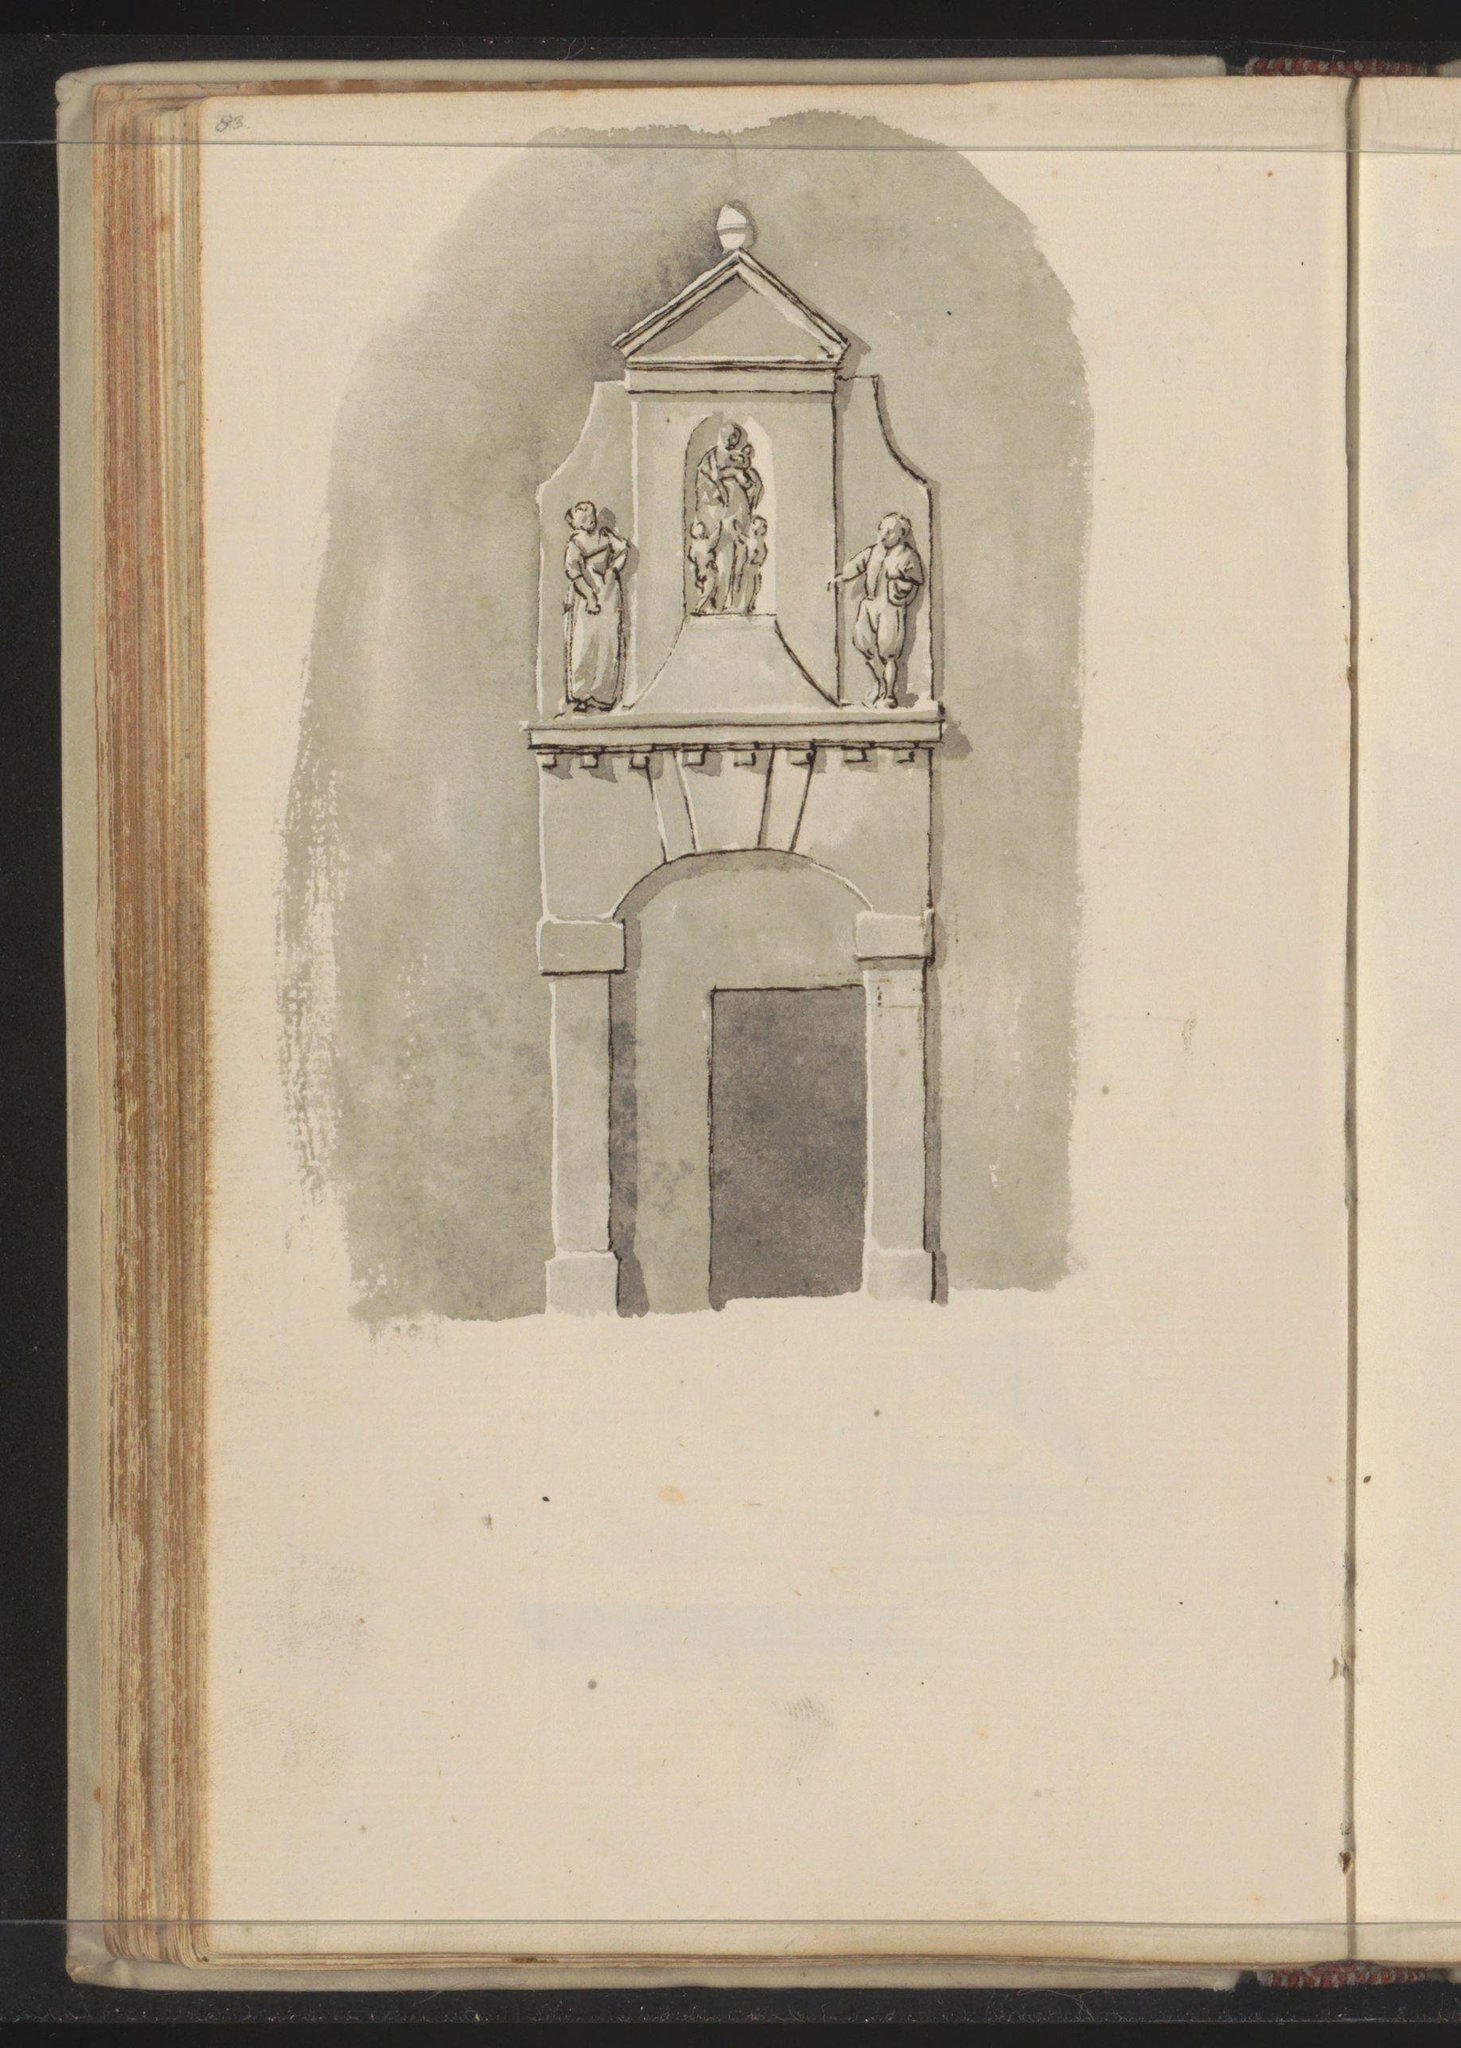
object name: sketchbook leaf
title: Geveltop met fronton en sculpturen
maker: johannes huibert prins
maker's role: draughtsman, painter, print maker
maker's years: 1757-1806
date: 1783-1797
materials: ink, paper, pencil, watercolor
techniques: brush, pen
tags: decorated gable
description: Pagina 83 uit een schetsboek met 175 pagina's.